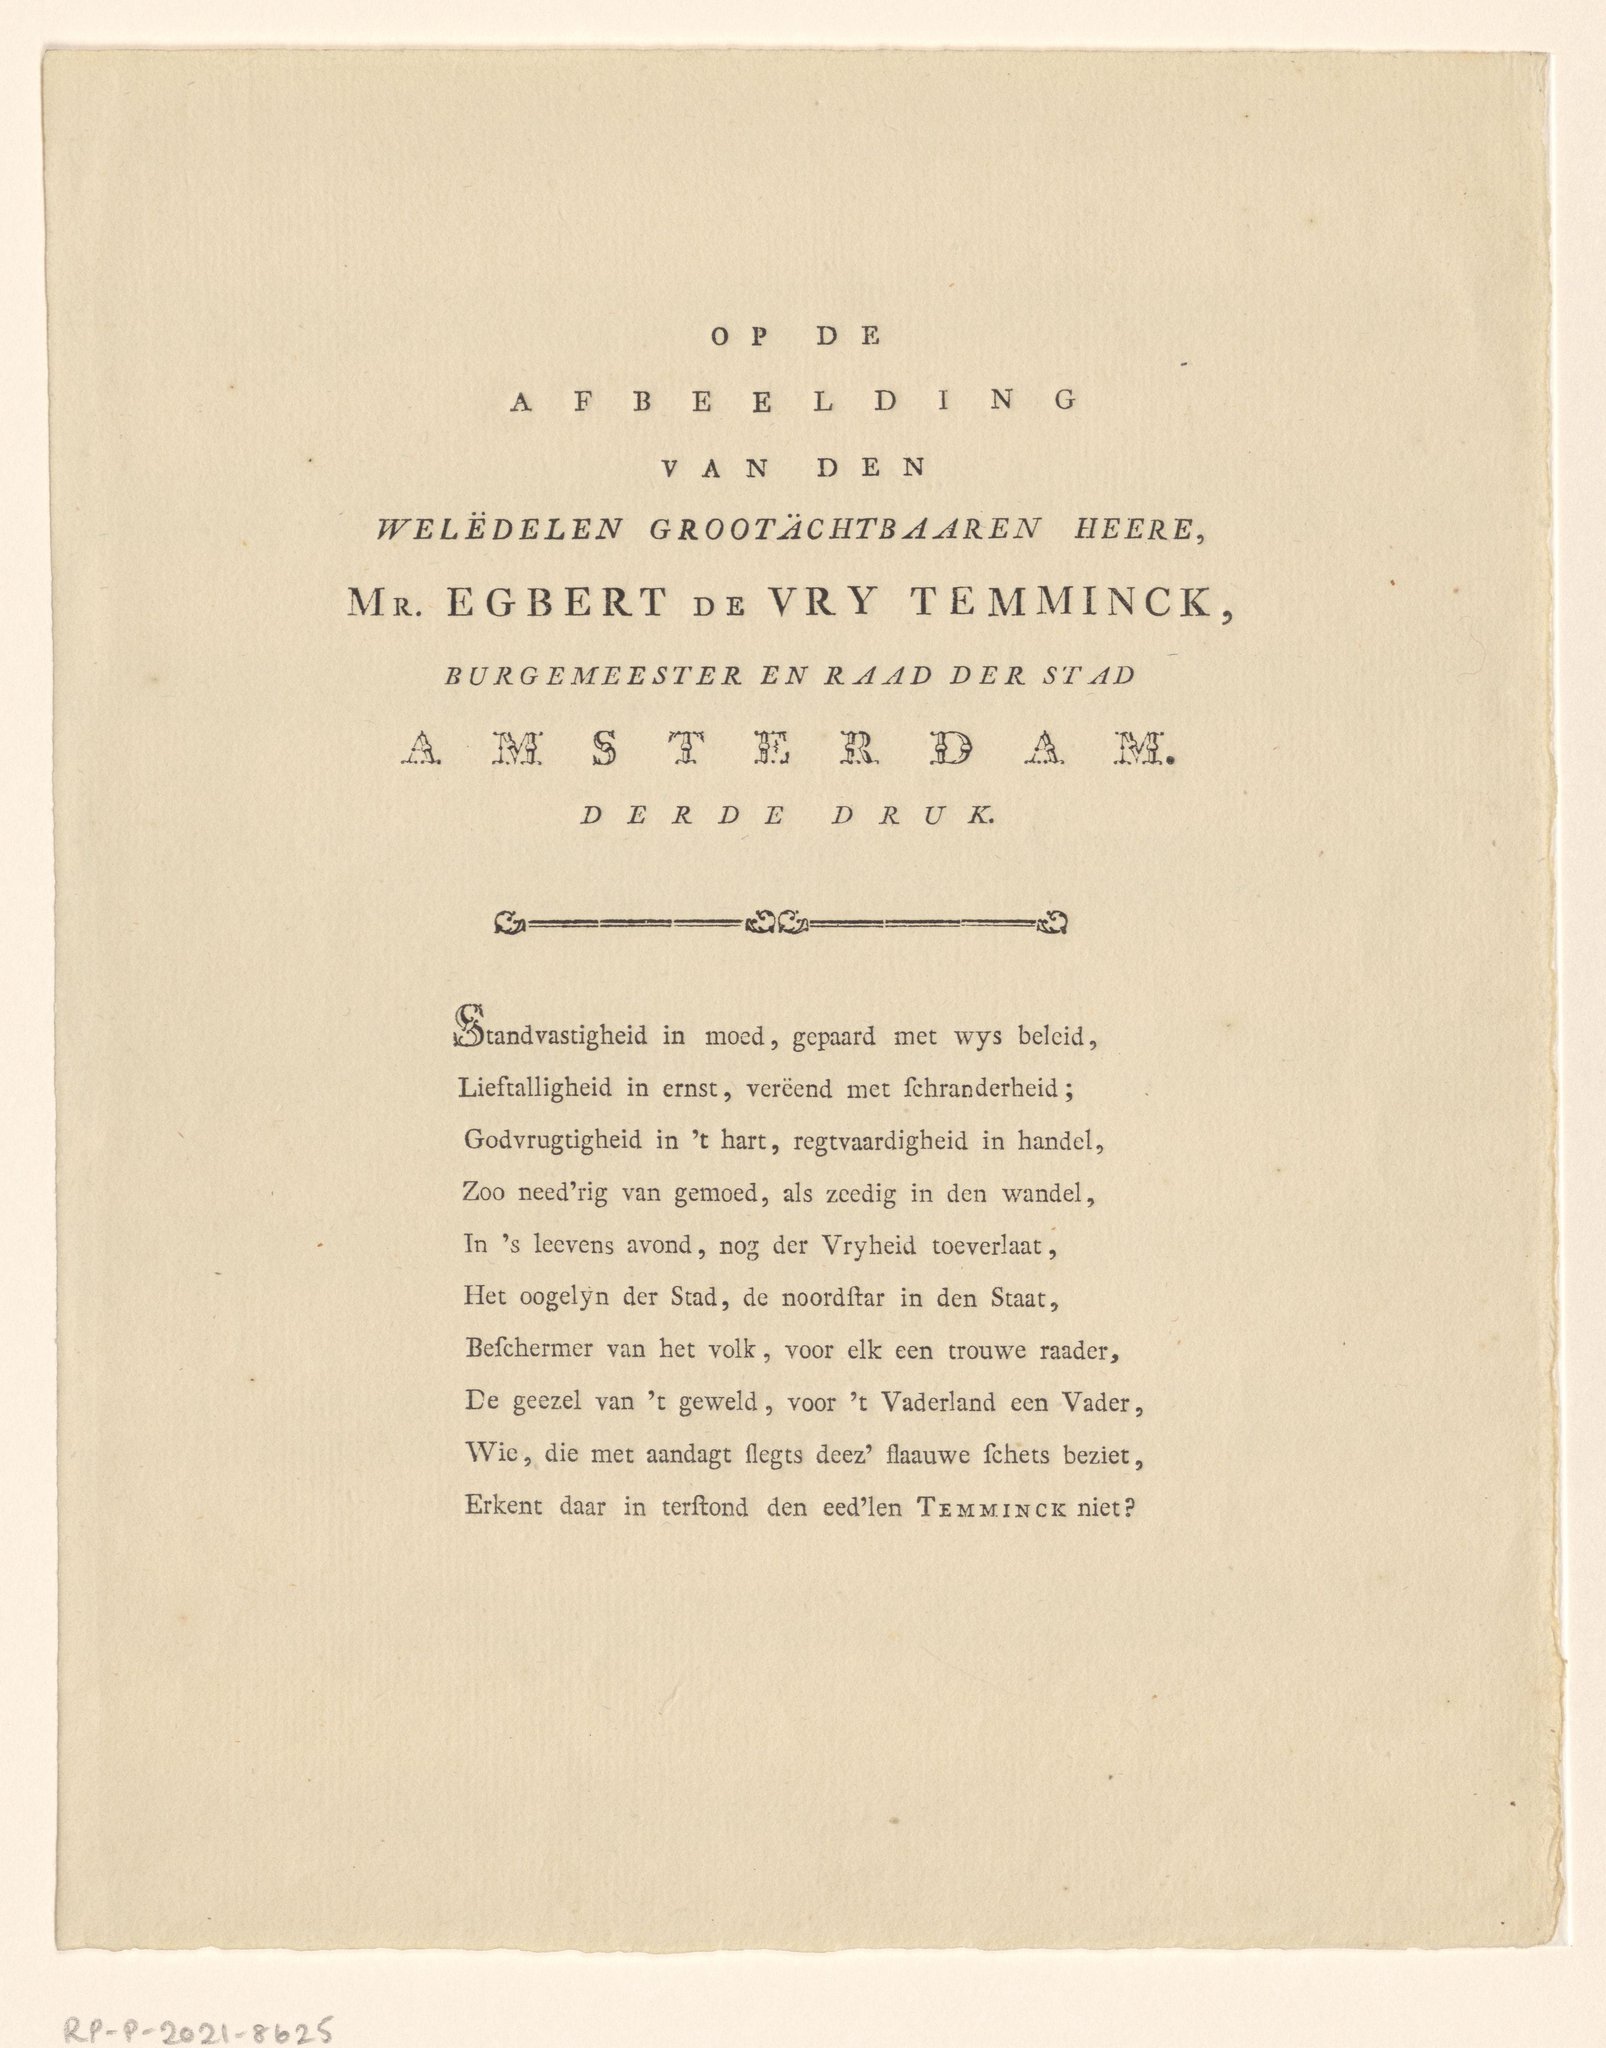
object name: text sheet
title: Tekstblad bij het portret van Egbert de Vrij Temminck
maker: Anonymous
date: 1781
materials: paper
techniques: letterpress printing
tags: mayor, egbert de vrij temminck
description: Mogelijk tekstblad bij het portret door Jacob Houbraken.